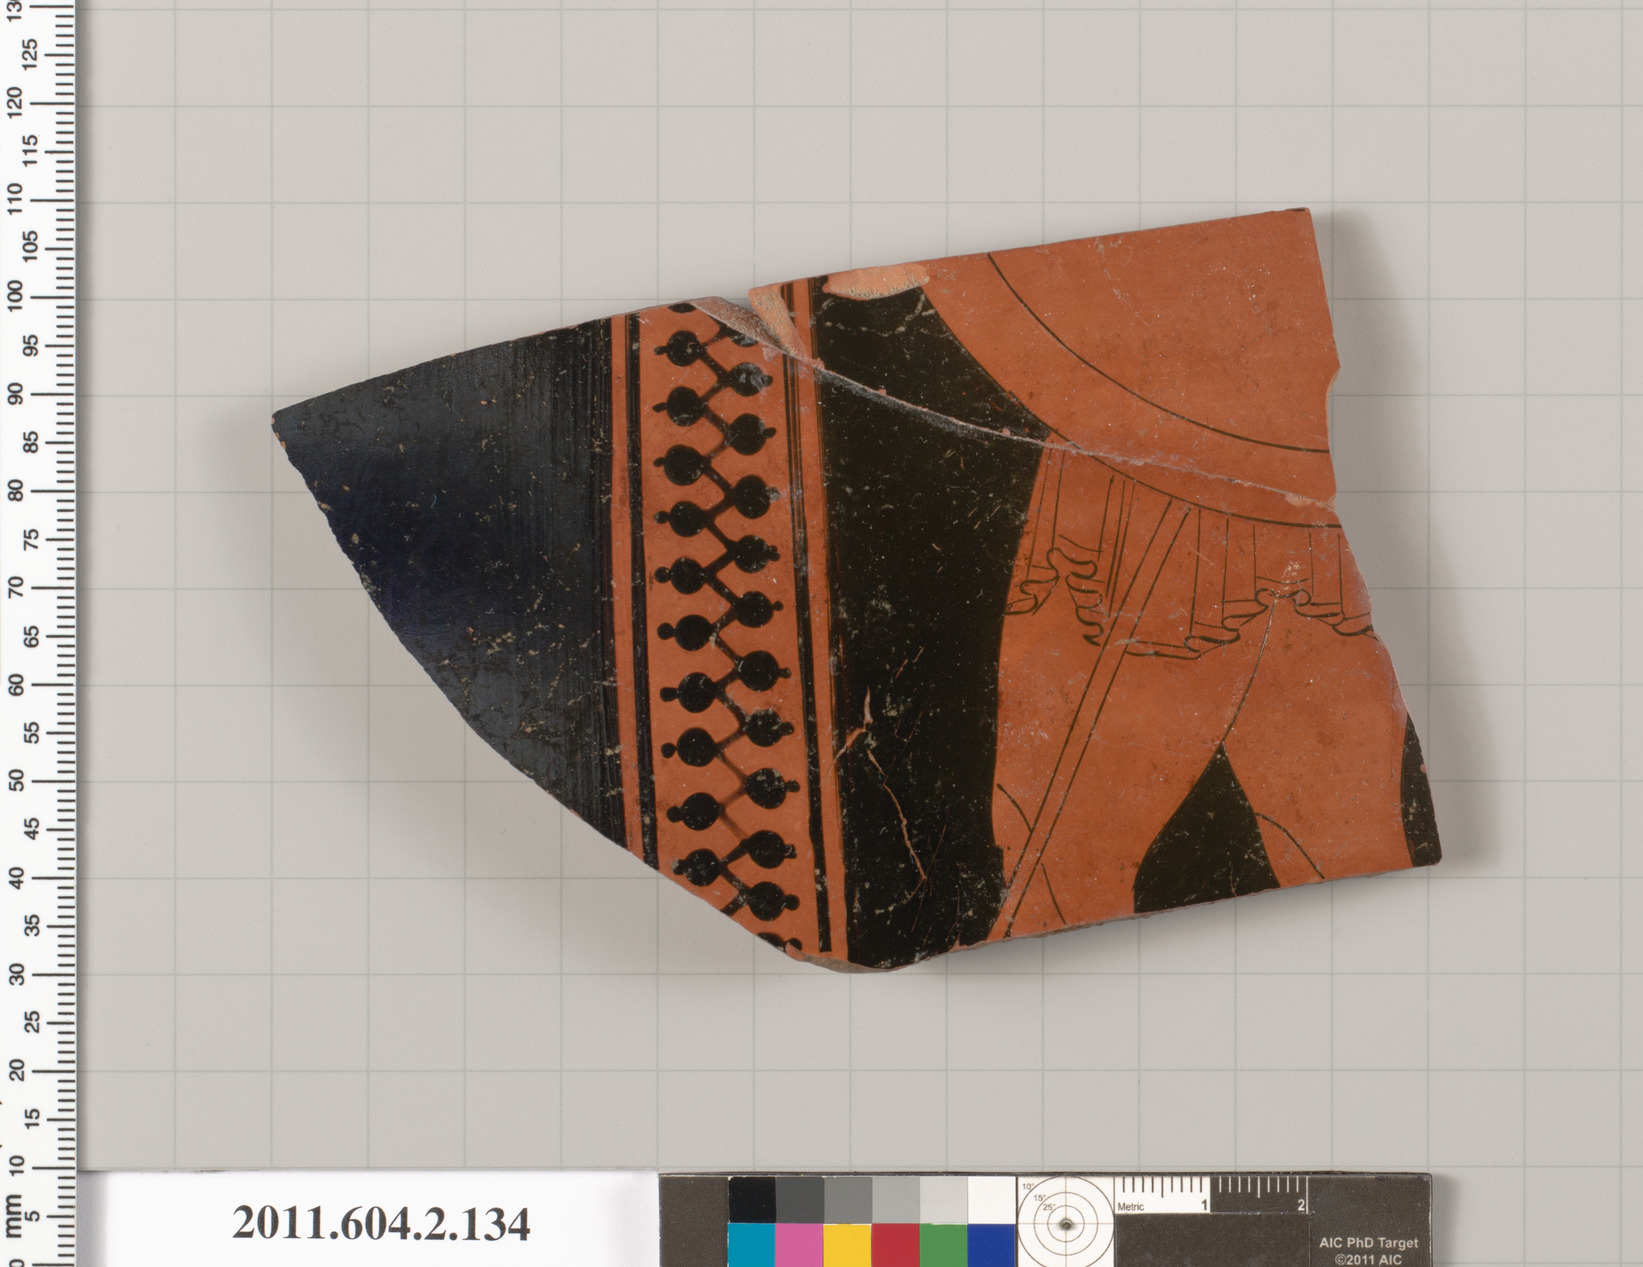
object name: pelike fragment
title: Terracotta fragment of a pelike (jar)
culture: greek, attic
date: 510-490 BCE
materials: terracotta